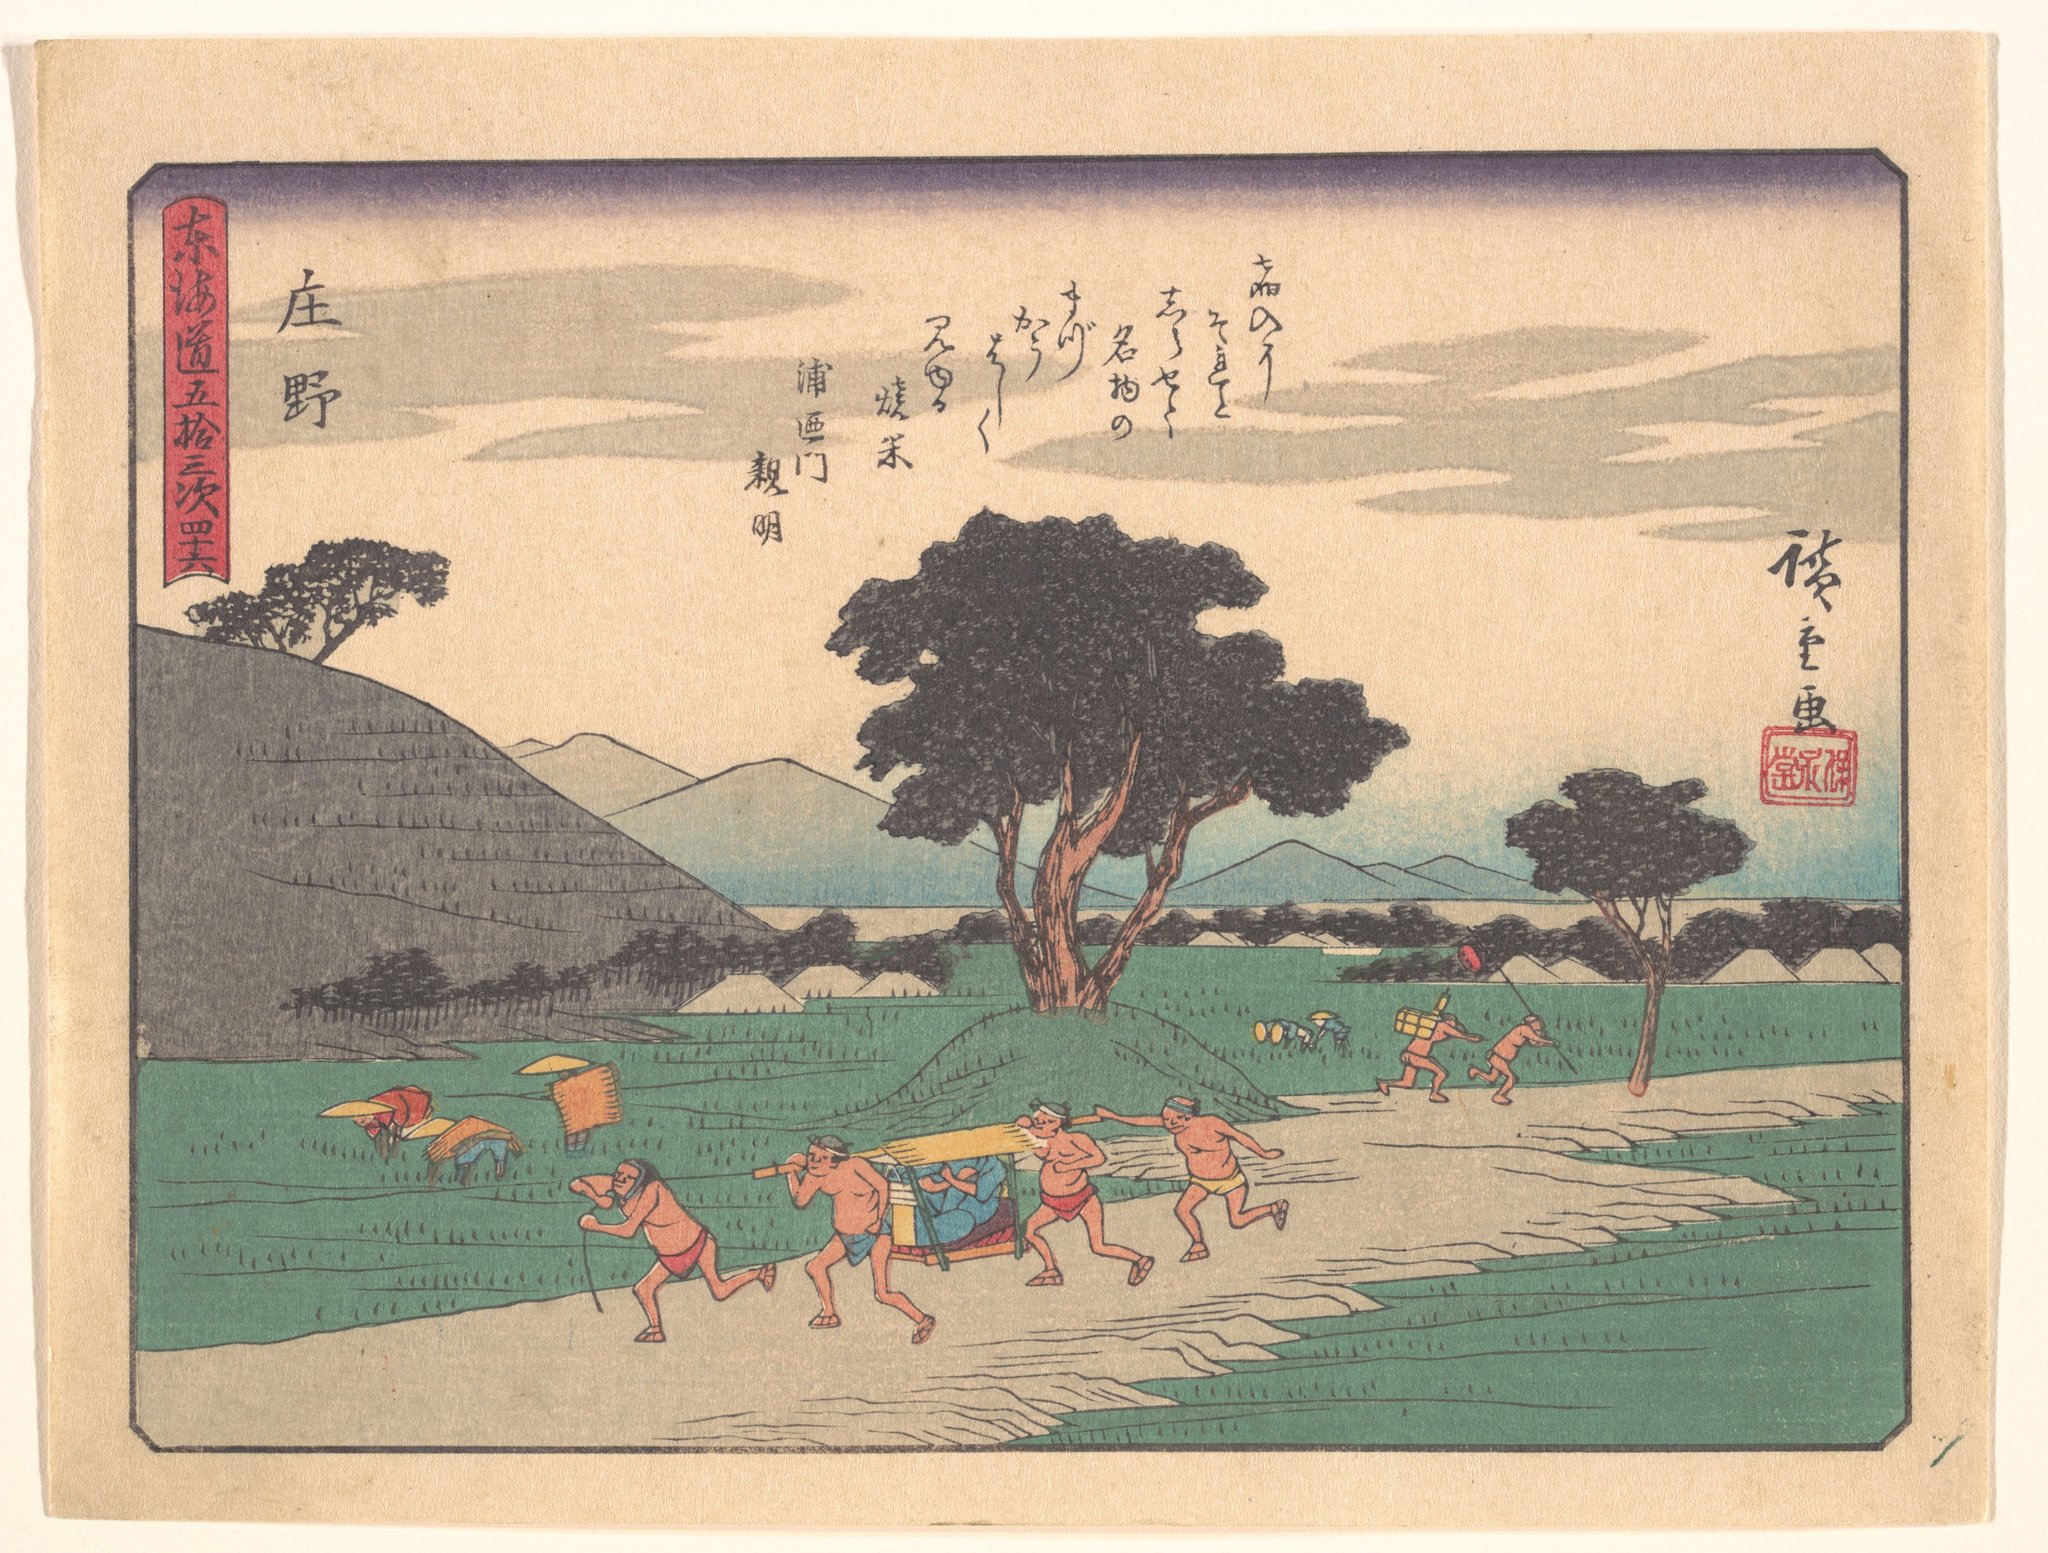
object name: print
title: Shōno, from the series The Fifty-three Stations of the Tōkaidō Road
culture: japanese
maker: utagawa hiroshige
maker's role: artist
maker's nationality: japanese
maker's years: 1797-1858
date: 1901-1933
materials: ink, paper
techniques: woodblock print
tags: men,hills,trees